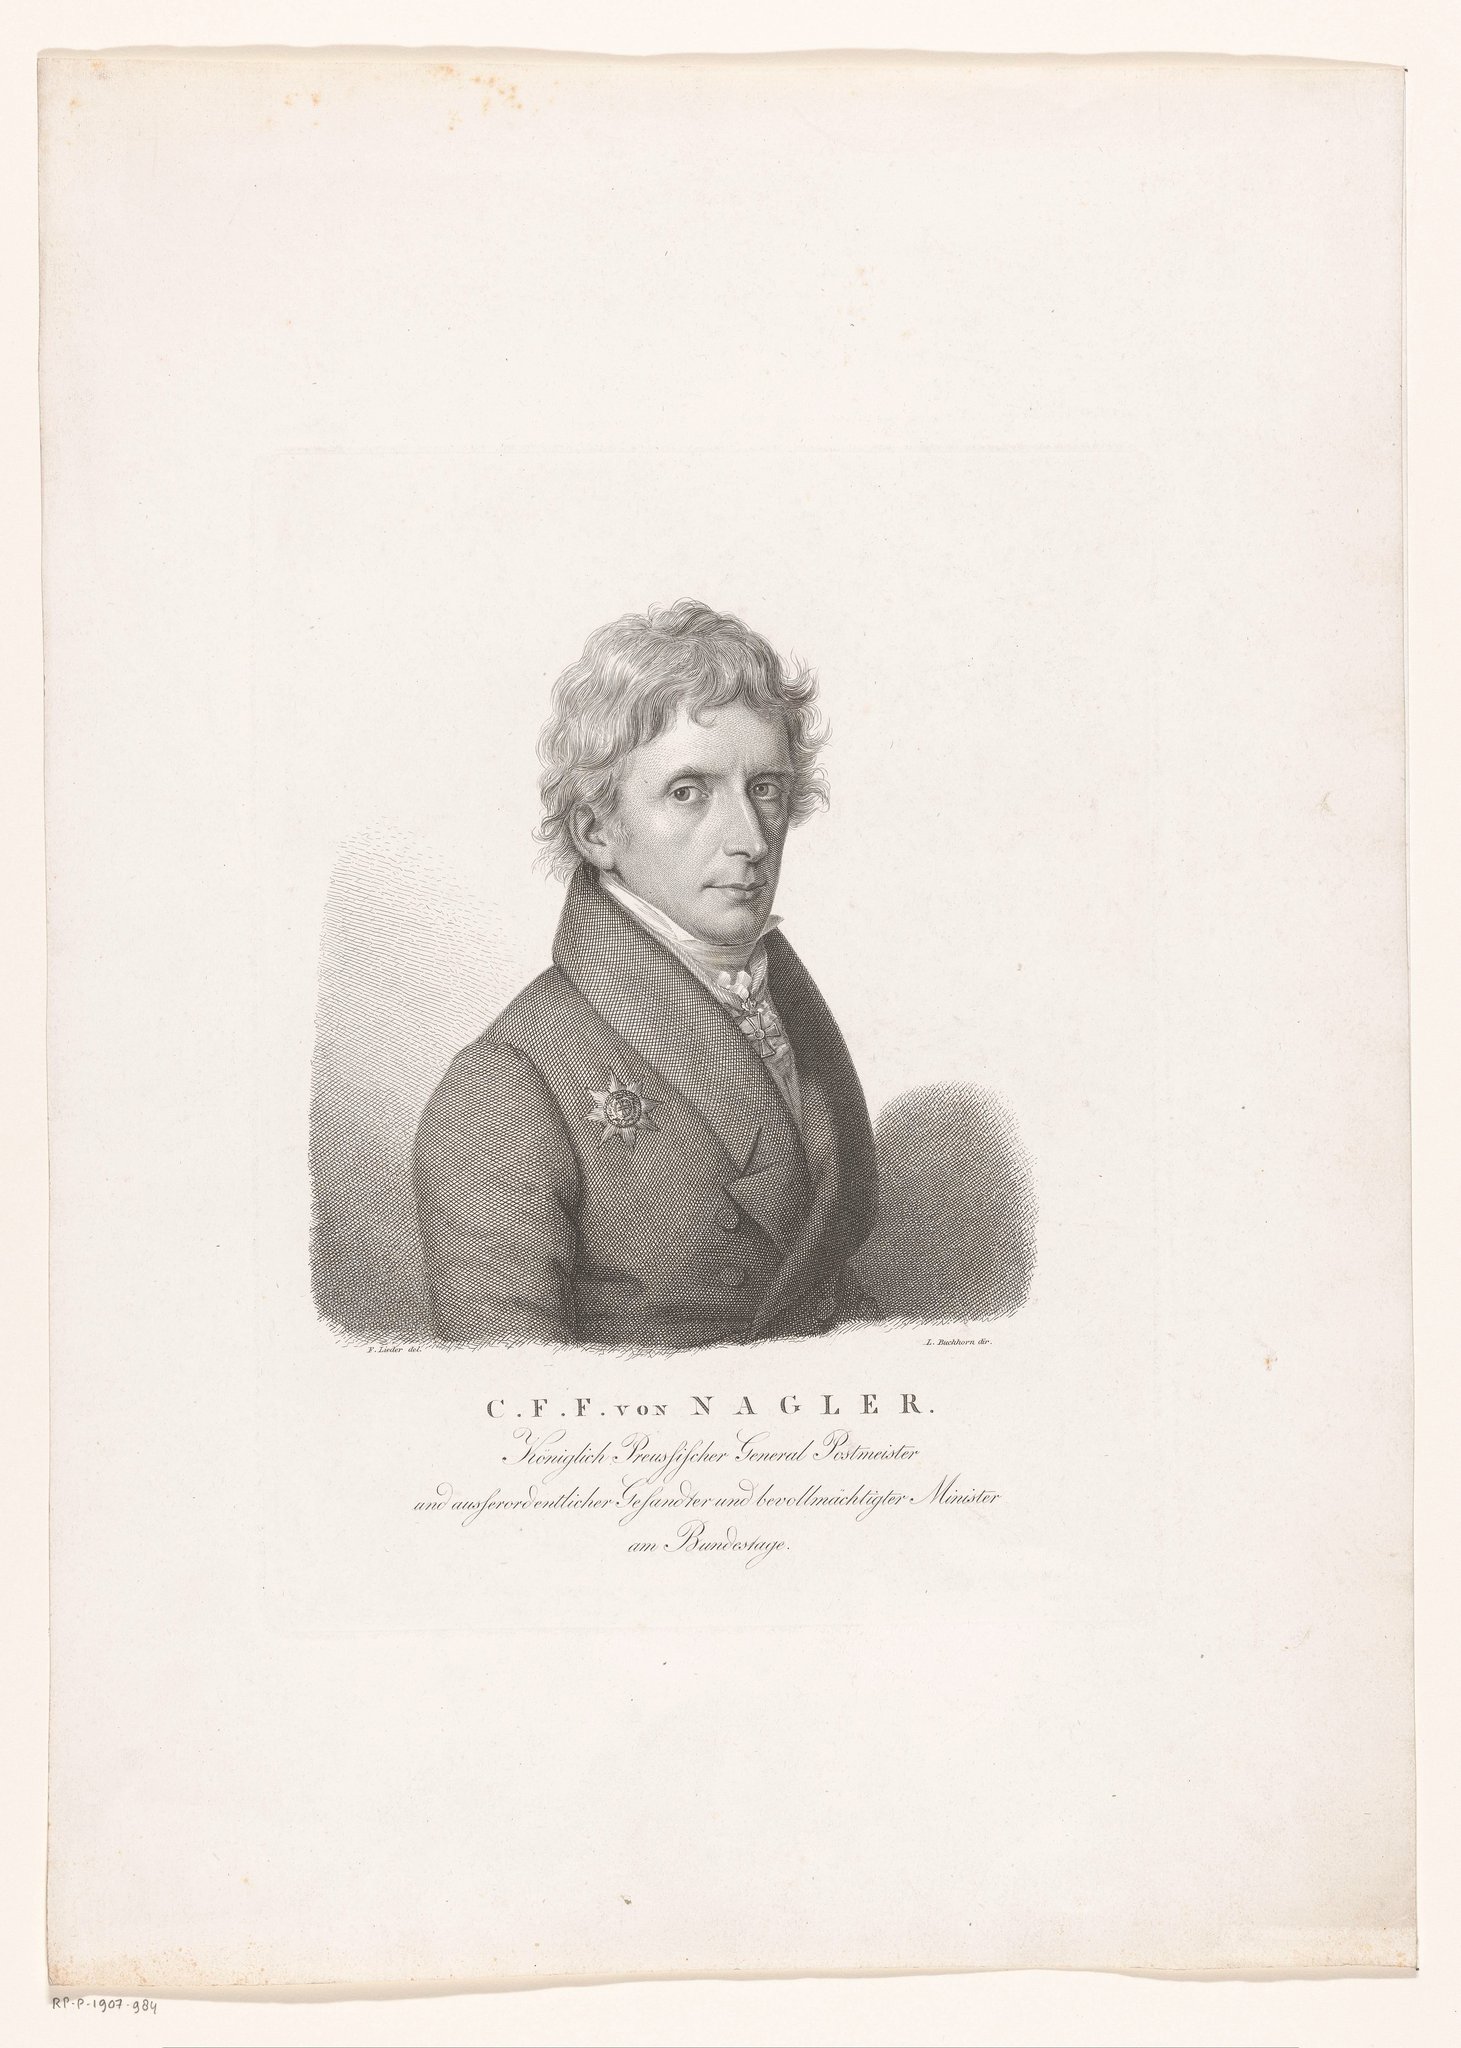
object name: print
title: Portret Carl Ferdinand Friedrich von Nagler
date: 1823-1856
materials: paper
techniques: engraving, etching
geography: berlin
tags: berlin, knighthood order, historical persons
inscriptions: collector's mark: Lugt 2228